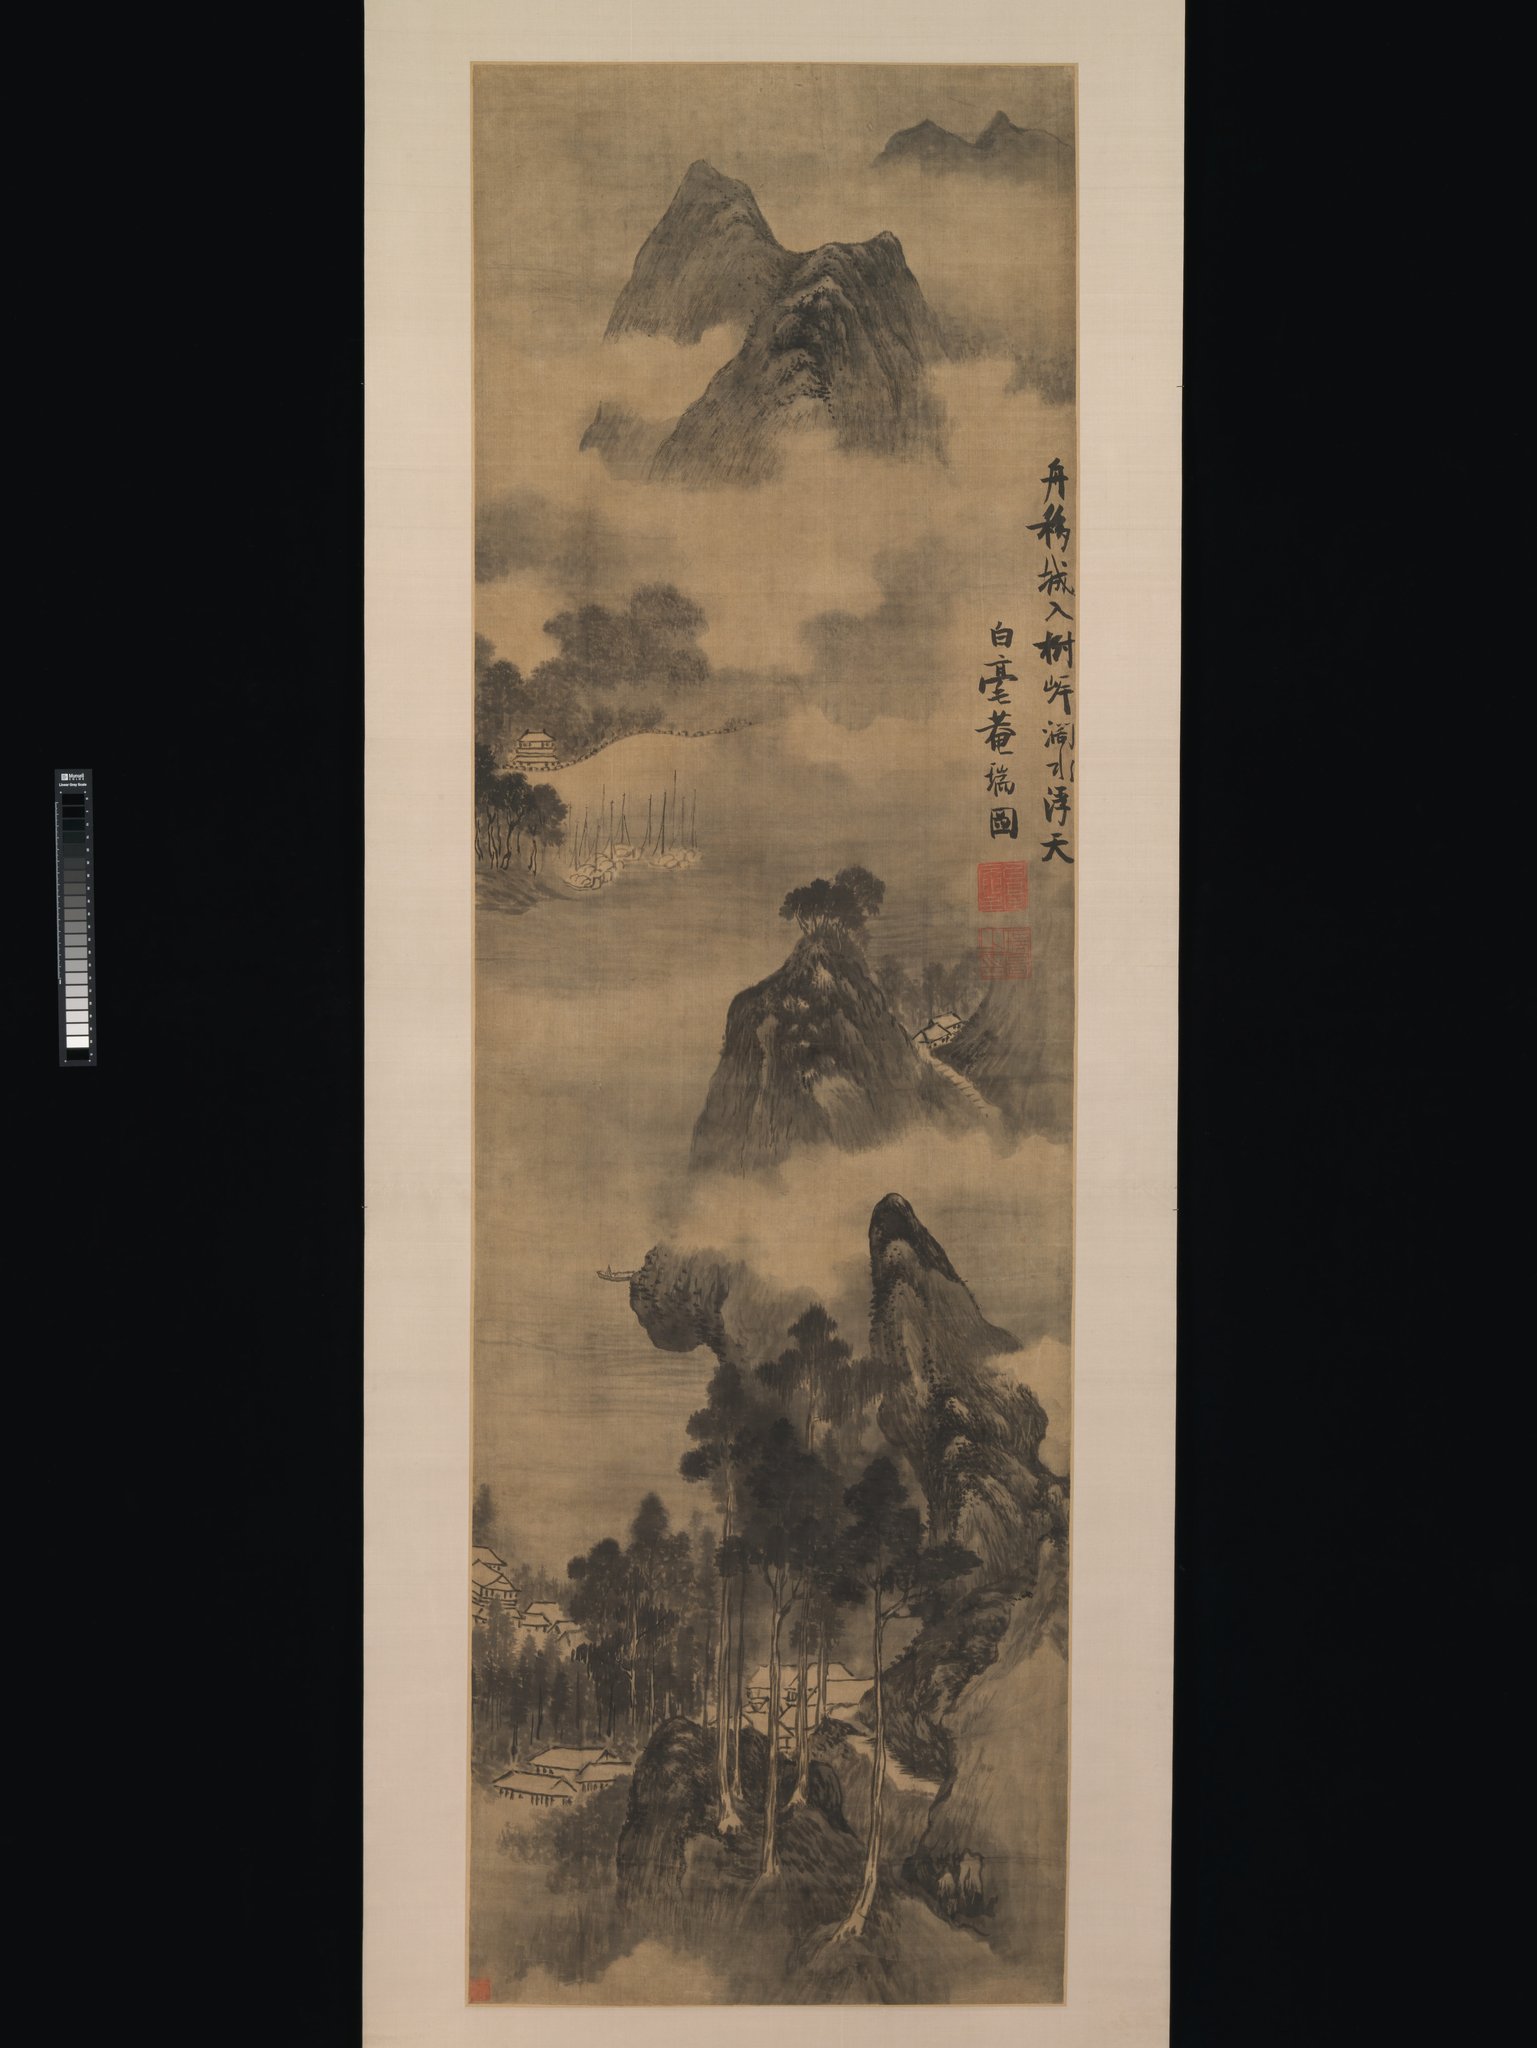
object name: hanging scroll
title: Landscape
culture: chinese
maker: zhang ruitu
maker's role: artist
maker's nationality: chinese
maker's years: 1570-1641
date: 1601-1633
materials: ink, textile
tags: mountains,landscapes,clouds